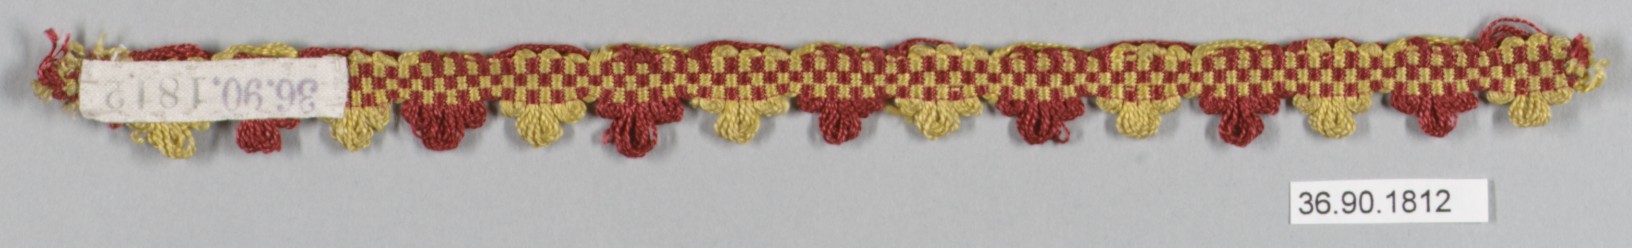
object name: fringe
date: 1767-1800